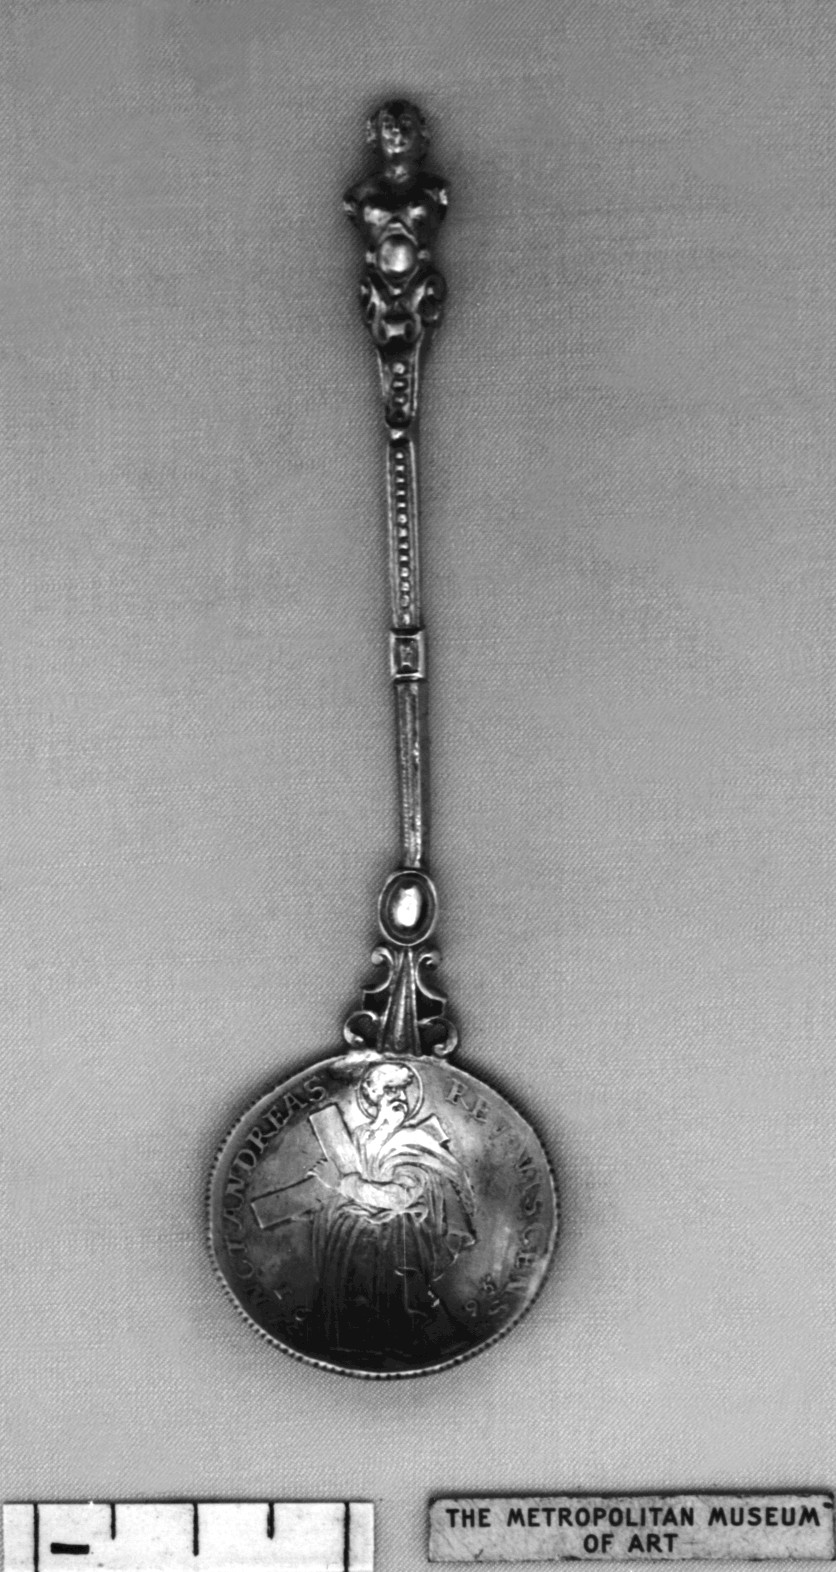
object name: salt or egg spoon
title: Salt or egg spoon (?)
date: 1601-1700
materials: gilt, silver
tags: men,female nudes,cross